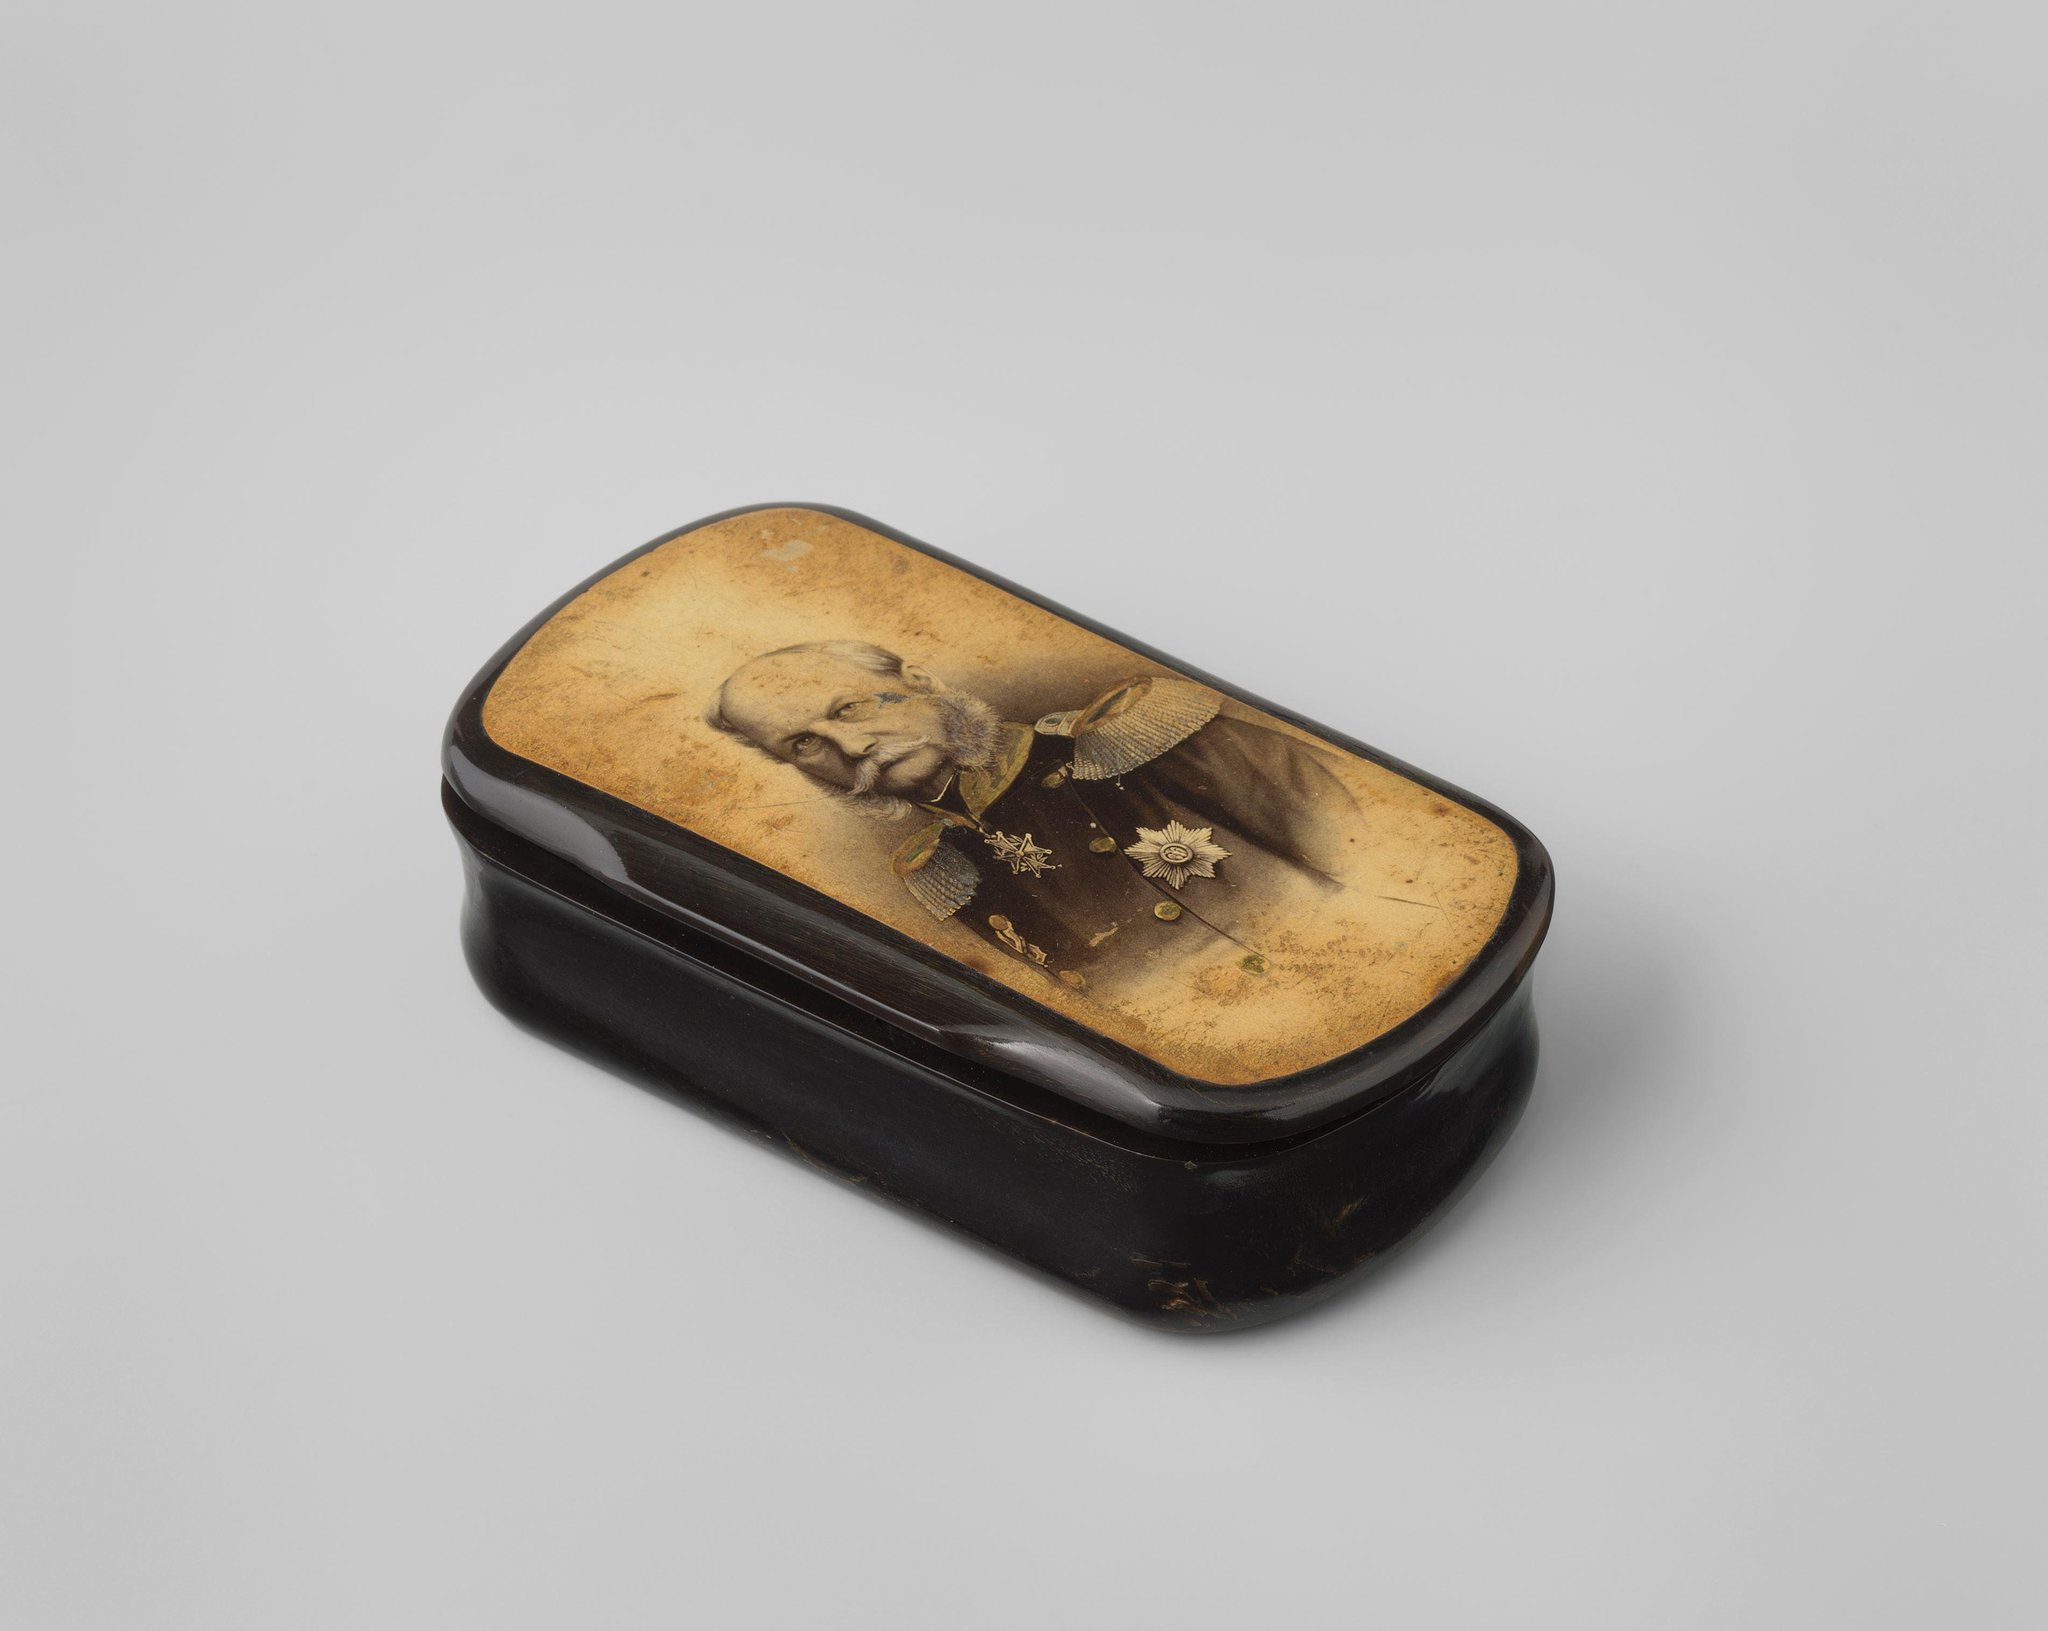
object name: lakdoos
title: Portret van keizer Wilhelm I van Duitsland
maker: Anonymous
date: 1870-1890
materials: lacquer, paper, wood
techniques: albumen print, hand coloring, lacquer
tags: wilhelm i (keizer van duitsland), historical persons, emperor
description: Langwerpige lakdoos met op het deksel het portret van keizer Wilhelm I.